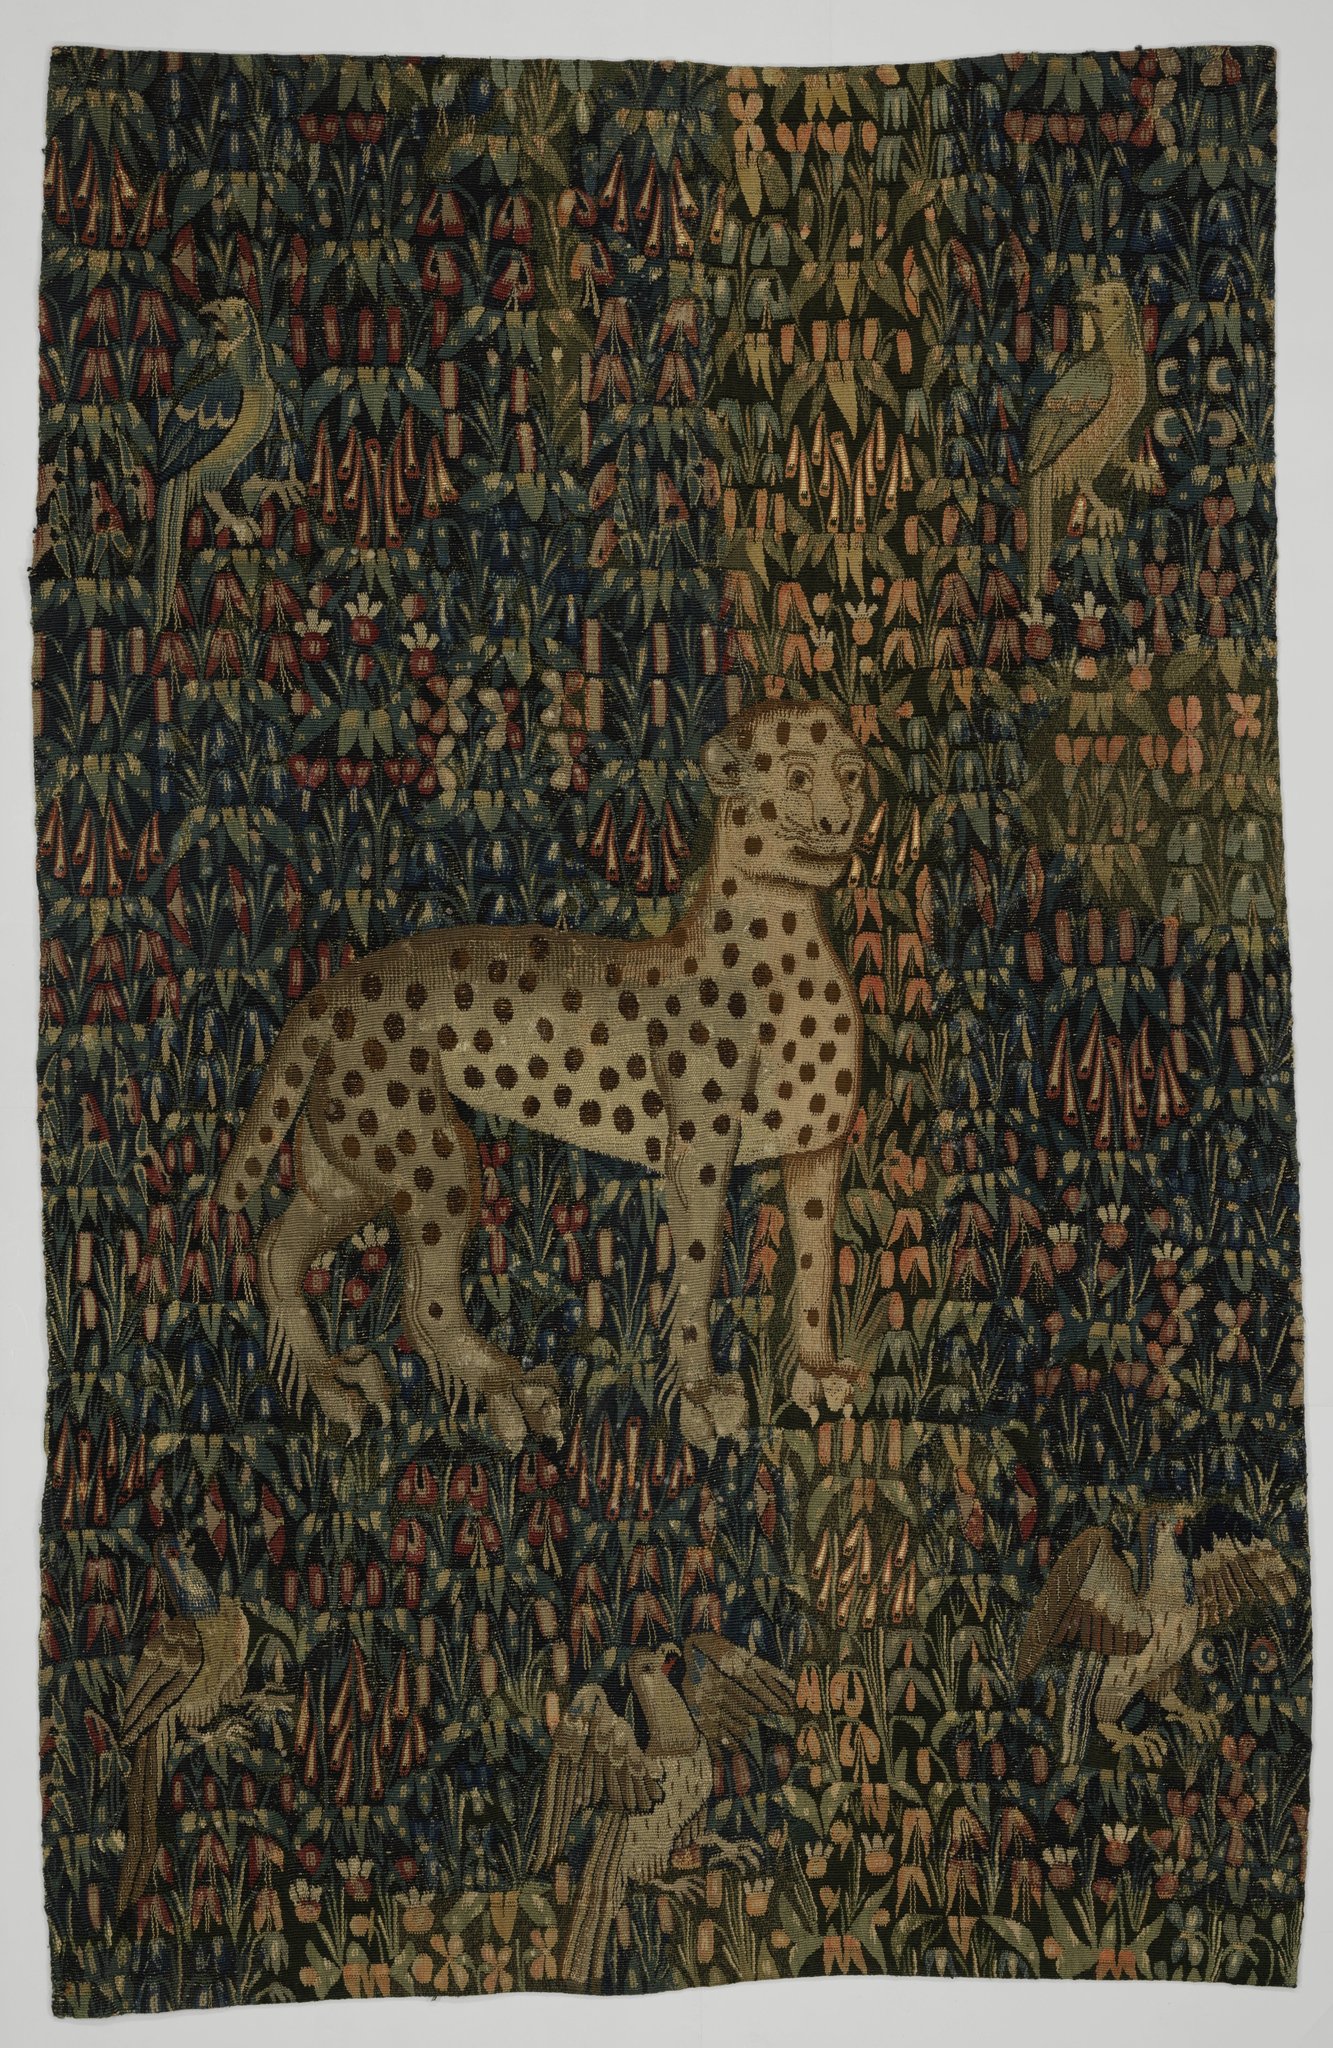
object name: tapestry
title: Millefleurs met een luipaard en vogels (fragment)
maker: Anonymous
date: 1500-1525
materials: wool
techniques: tapestry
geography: southern netherlands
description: C. Colonna, 'La tapisserie des cerfs ailés', L'Estampille. L'object d'art, 401 (2005), p. 48. Vermeldt en toont een wandtapijt met een vergelijkbare soort achtergrond. Koenraad Brosens, European tapestries in the Art Institute of Chicago, Chicago 2008, p. 210, fig. 4. Vermeldt en toont een wandtapijt met een vergelijkbare soort achtergrond.